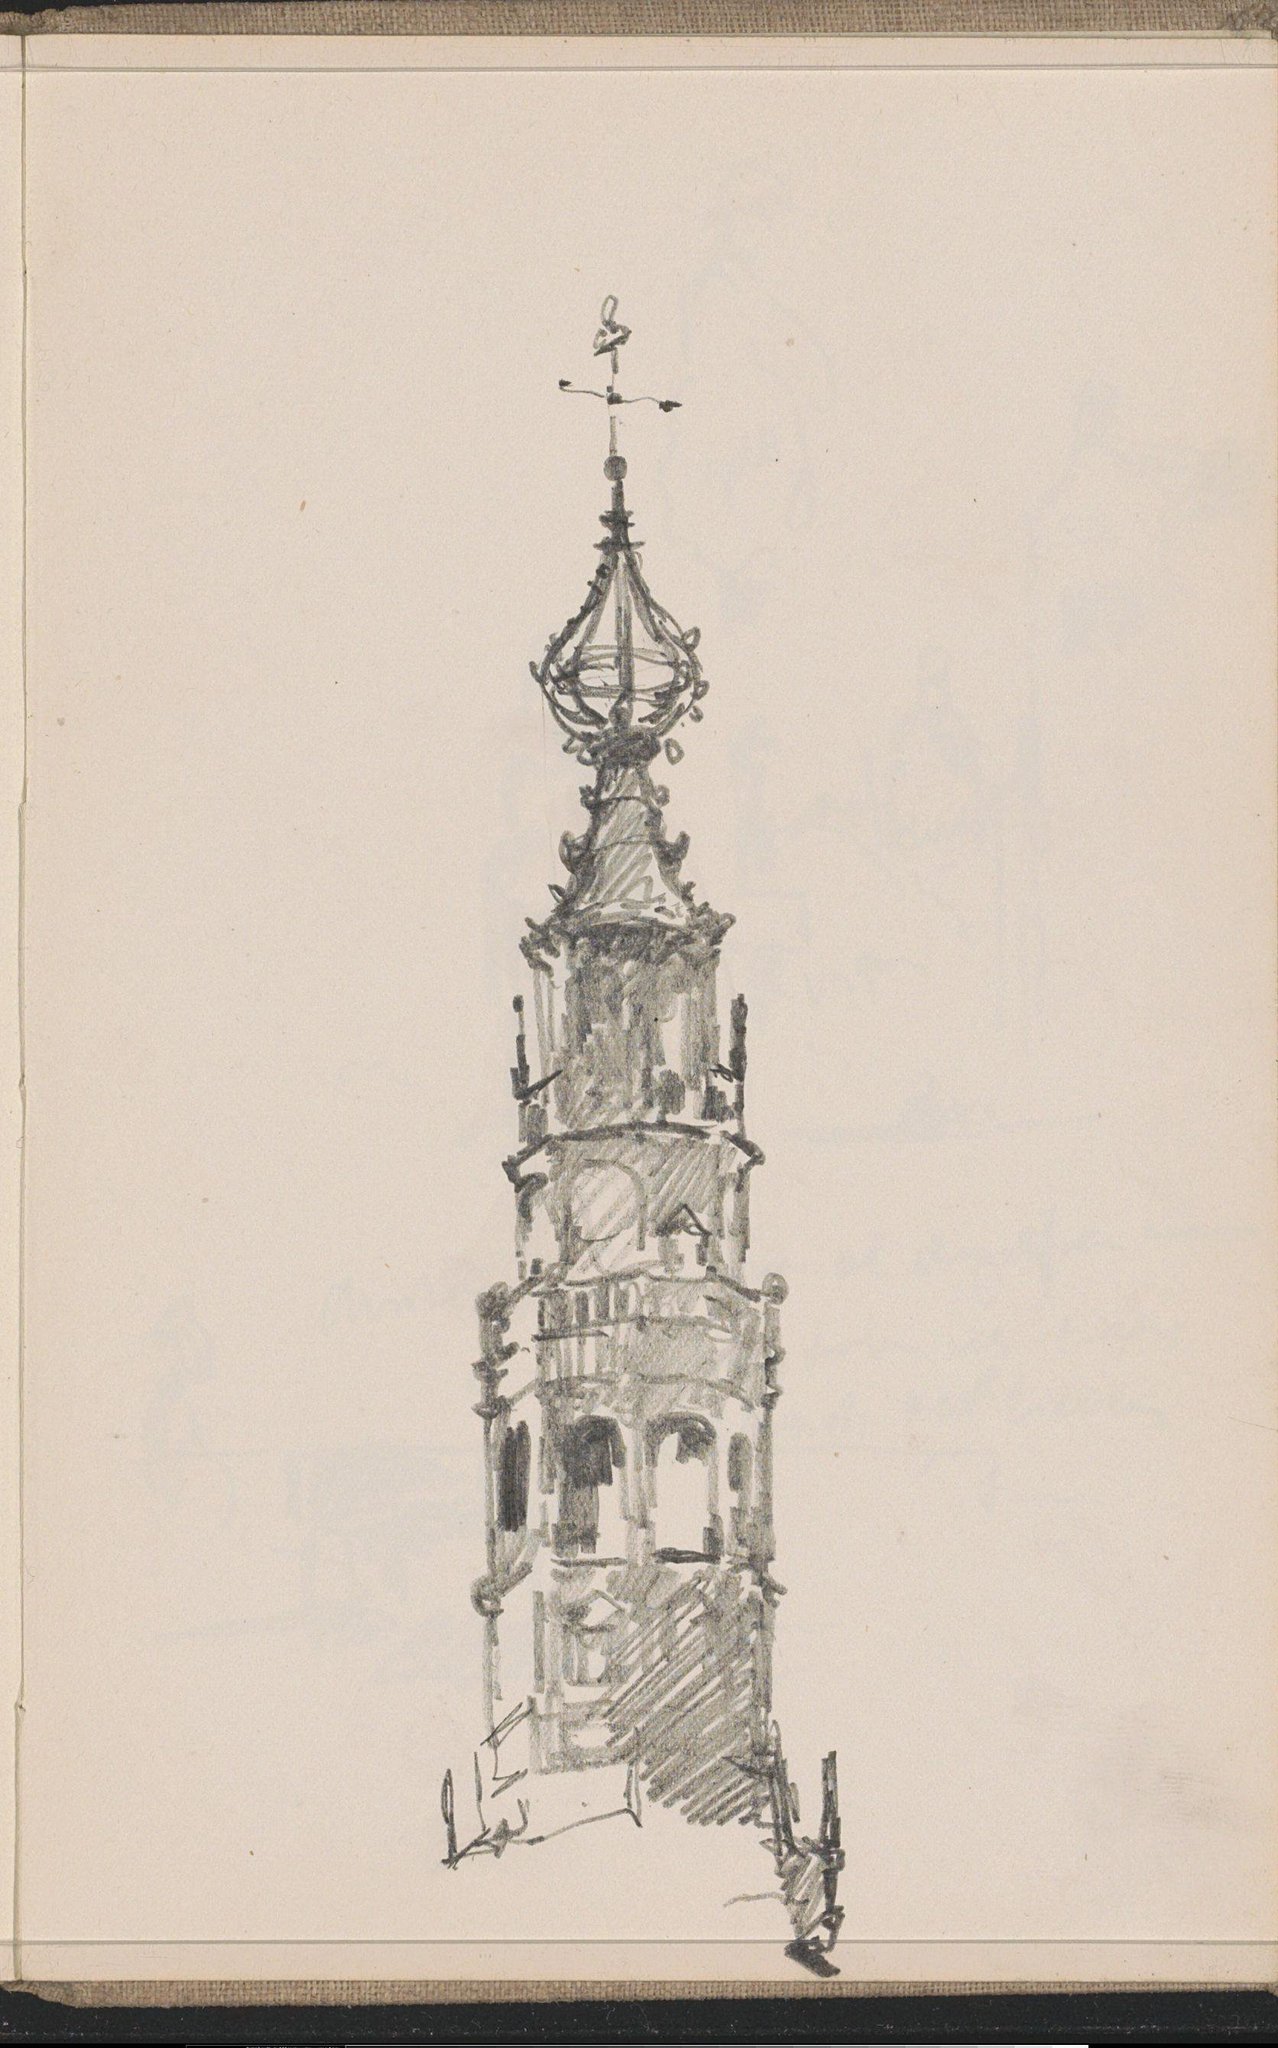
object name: sketchbook leaf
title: Kerktoren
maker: cornelis vreedenburgh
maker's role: draughtsman, print maker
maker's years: 1880-1946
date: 1890-1946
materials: paper, pencil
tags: parts of church exterior and annexes: tower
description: Blad 36 recto uit een schetsboek met 41 bladen.